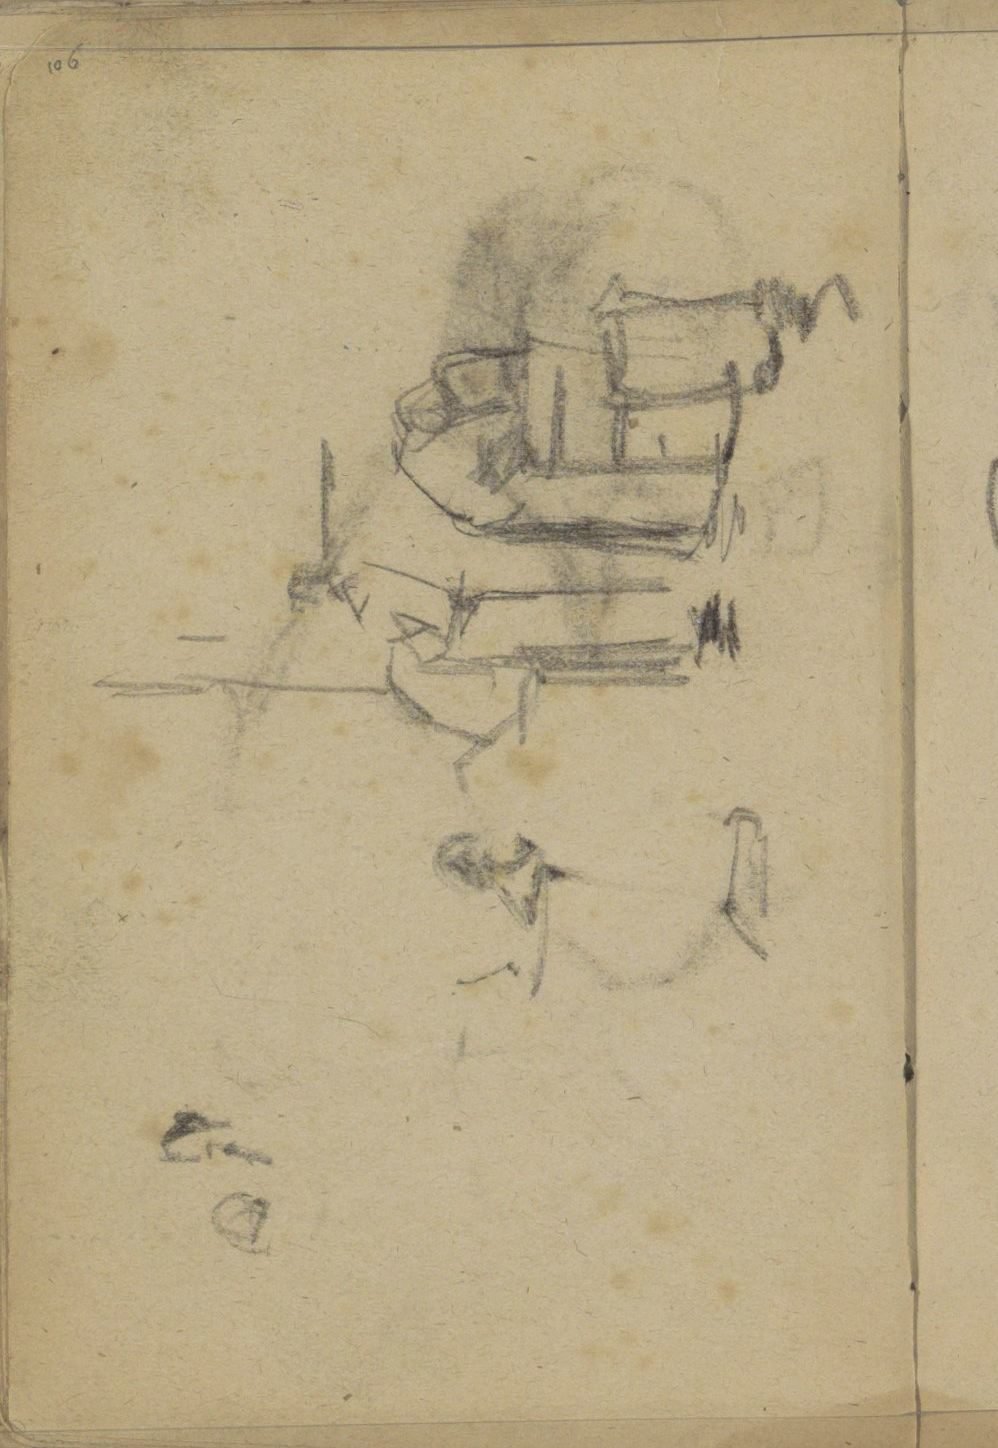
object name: sketchbook leaf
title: Vrouw, mogelijk een wasvrouw, bij een mand of ton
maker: george hendrik breitner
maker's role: draughtsman, painter, print maker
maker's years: 1857-1923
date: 1881-1883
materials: chalk, paper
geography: south holland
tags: adult woman, laundering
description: Vrouw, mogelijk een wasvrouw, staat bij een mand of ton. Pagina 106 uit een schetsboek met 70 bladen.